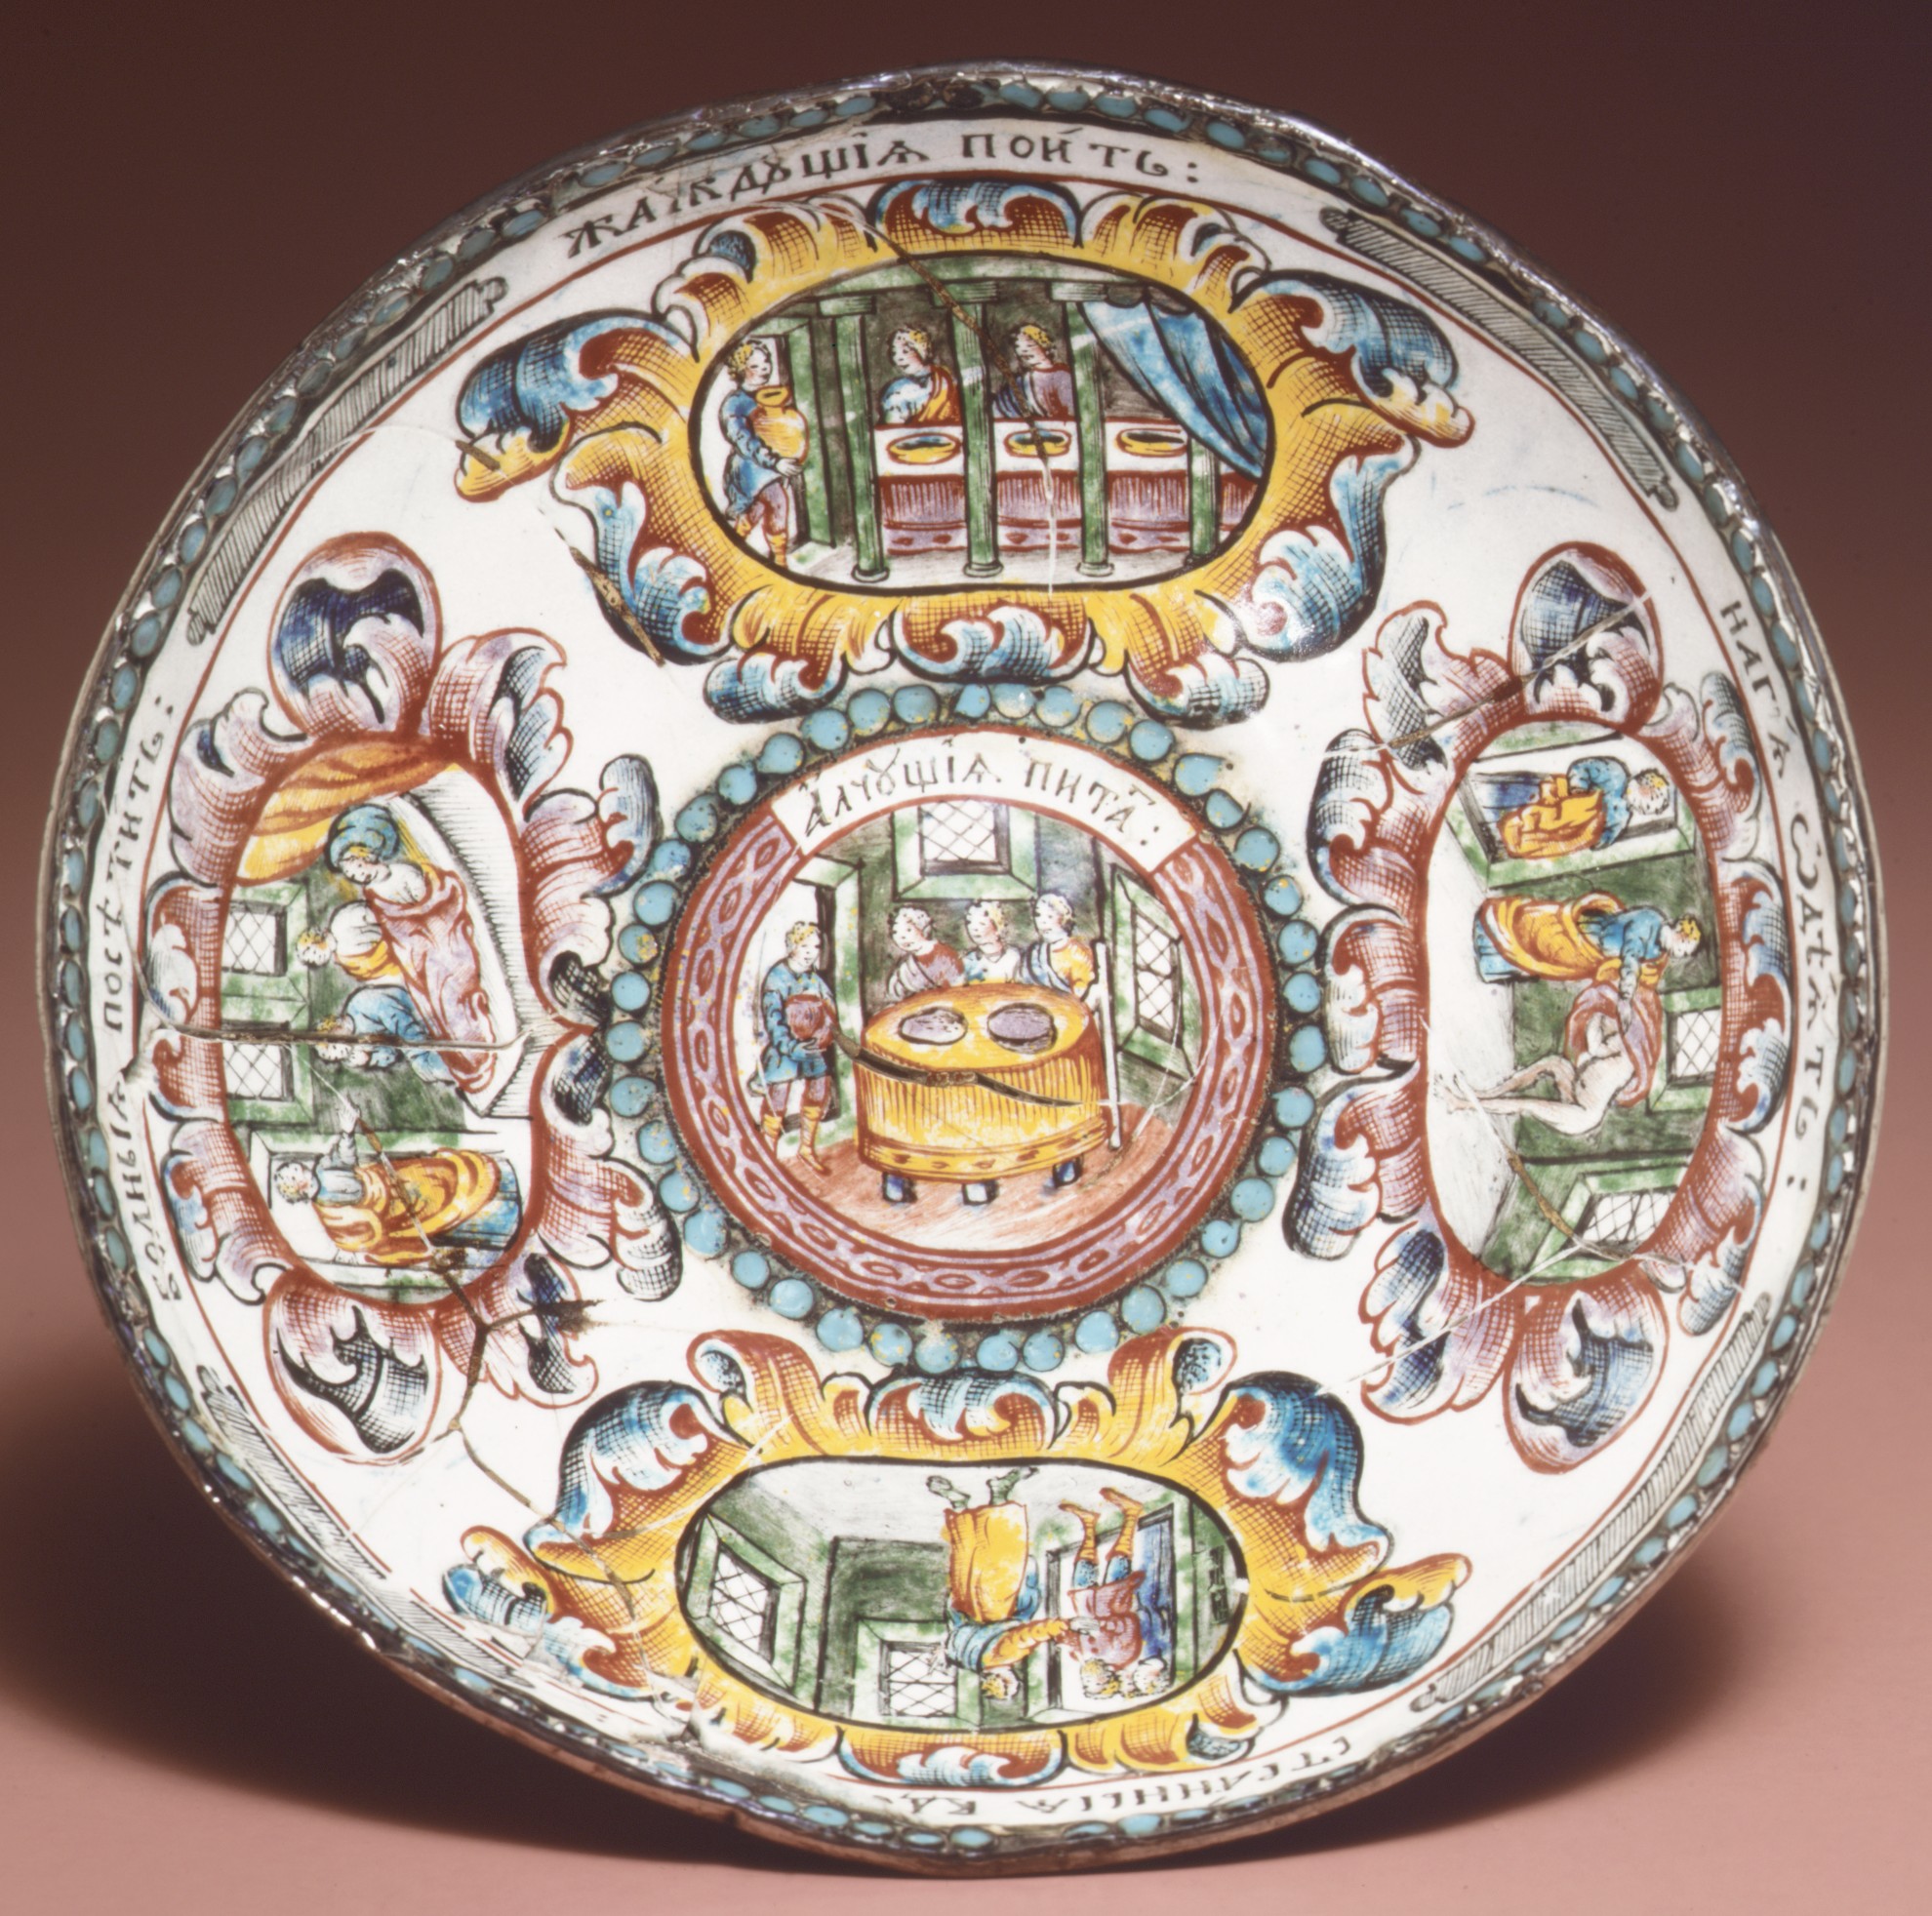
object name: bowl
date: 1601-1700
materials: enamel, silver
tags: human figures